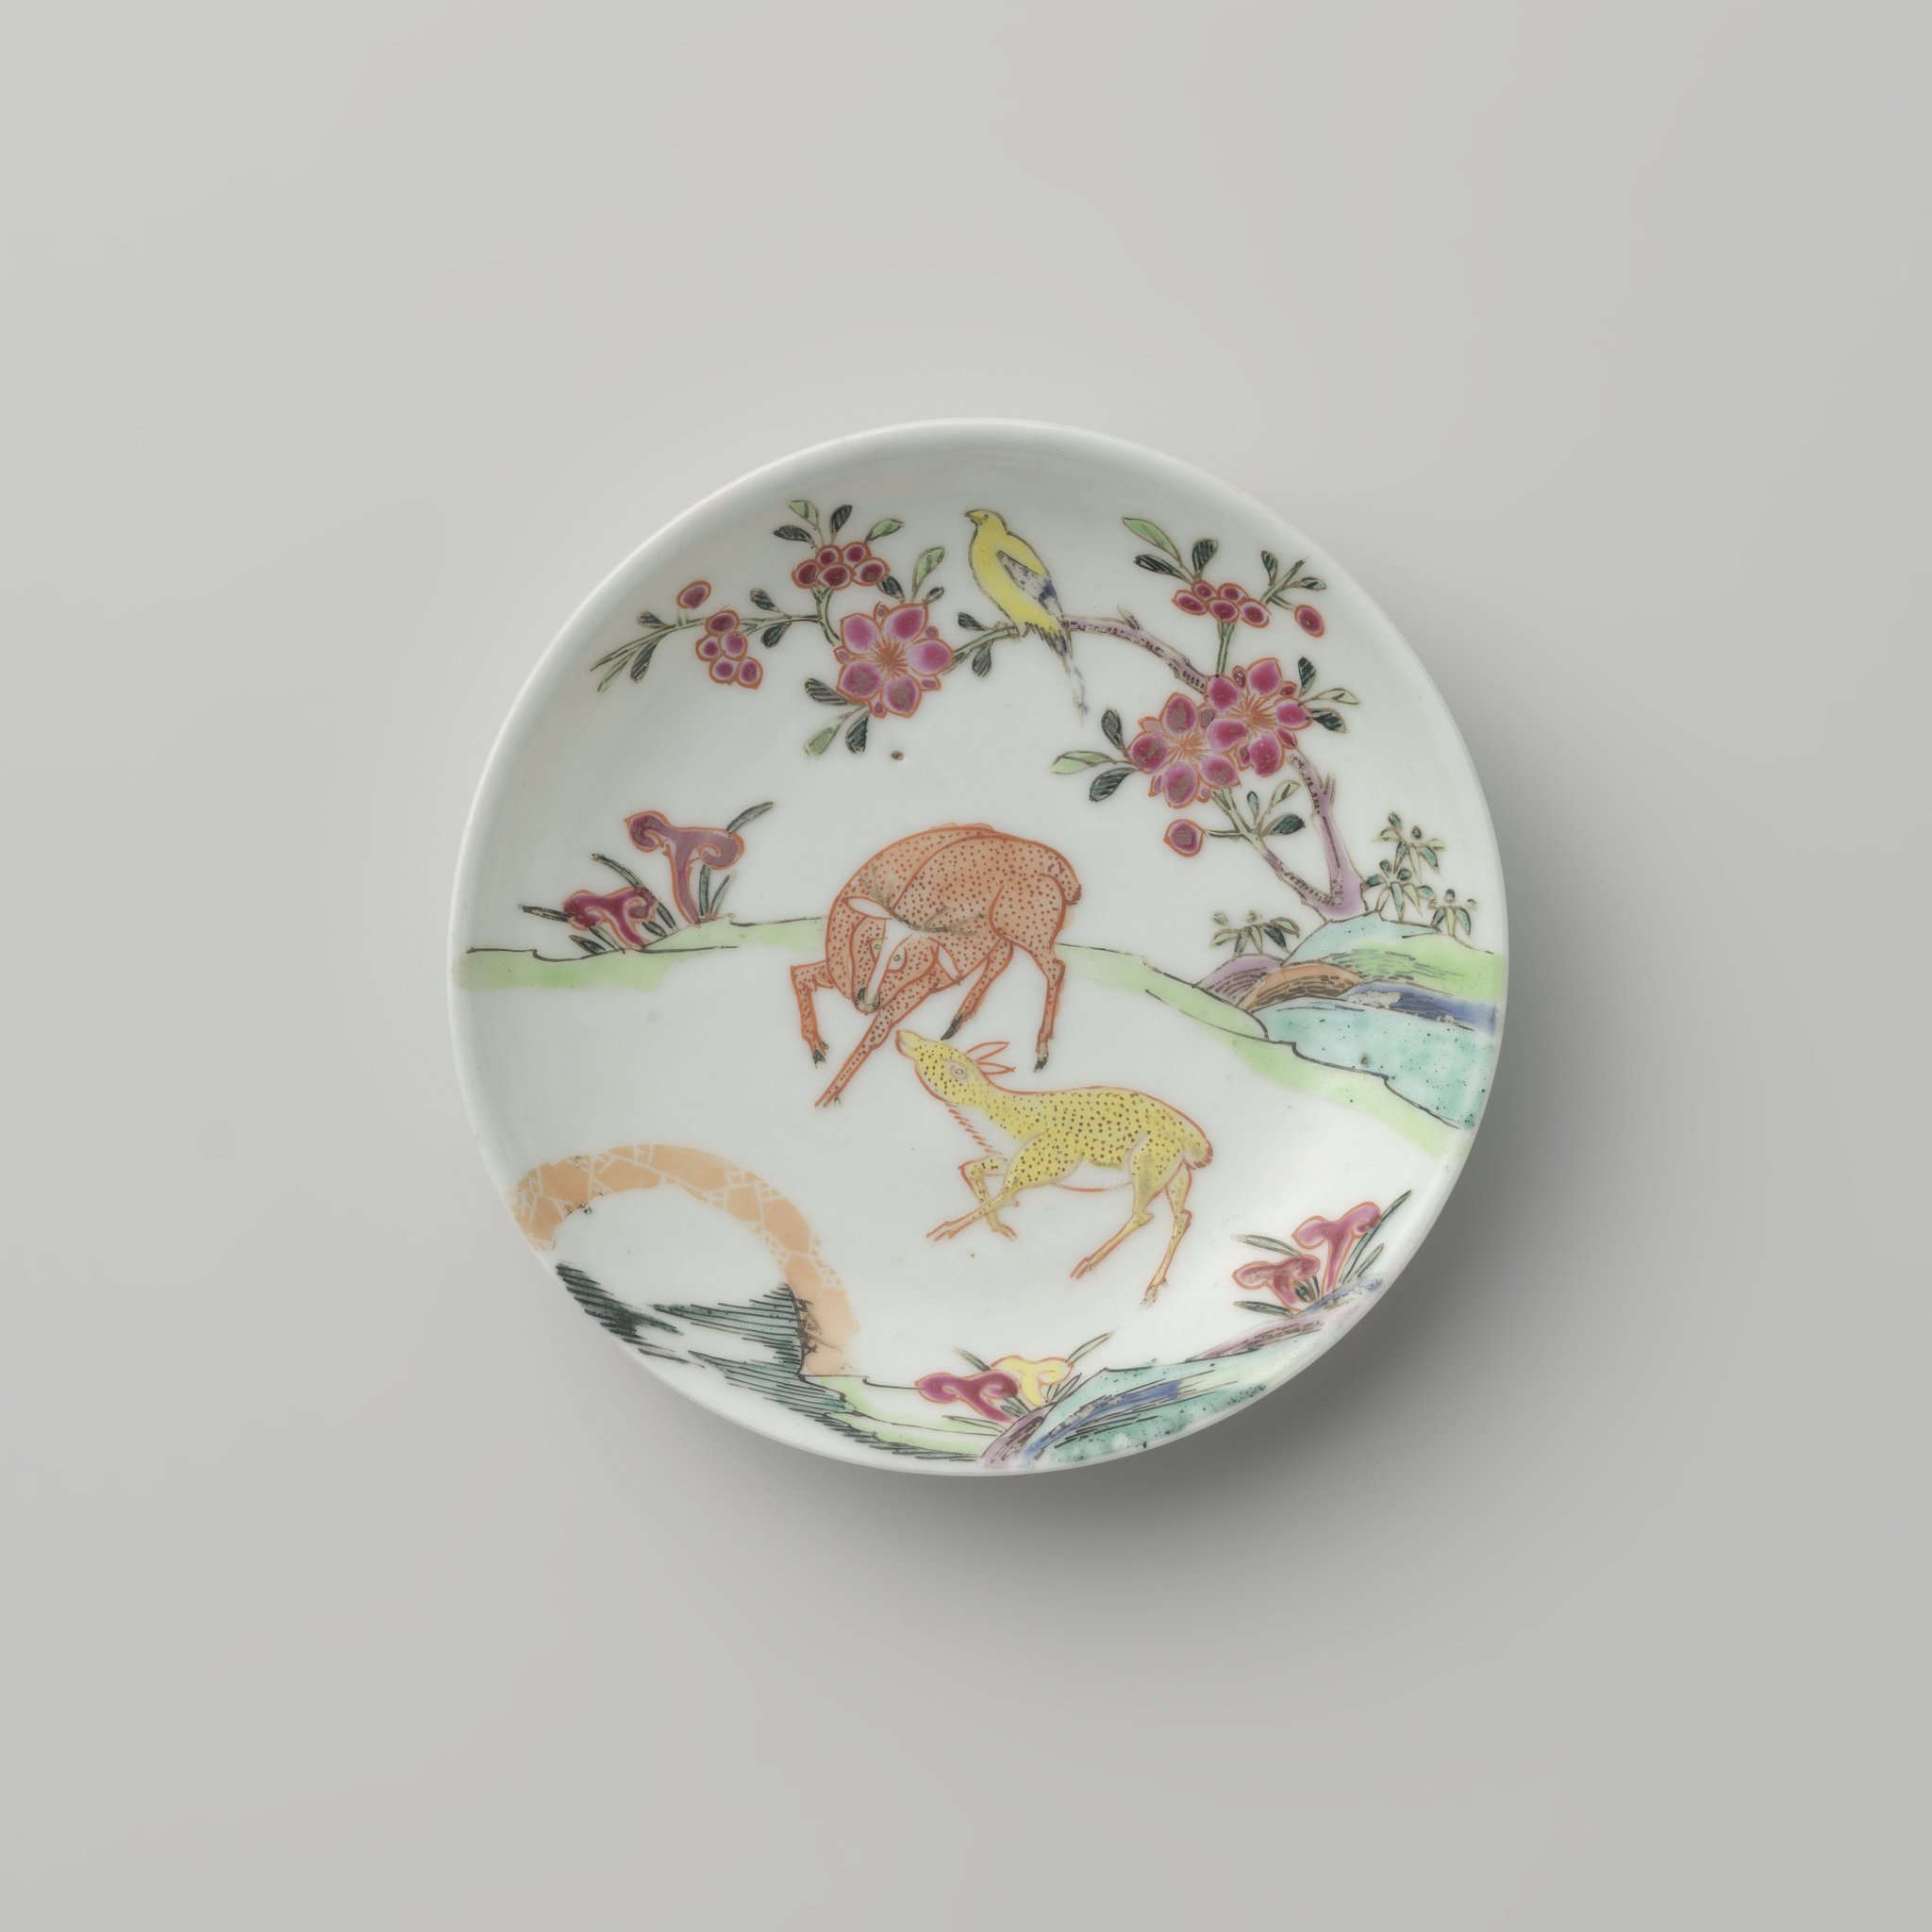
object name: kop en schotel, kop en schotel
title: Saucer with two deer in a landscape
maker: Anonymous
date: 1725-1749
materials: glaze, paint, porcelain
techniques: firing, turning, vitrification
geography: china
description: Schotel van porselein, beschilderd op het glazuur in blauw, rood, roze, groen, geel en zwart. Op het plat van de schotel twee herten in een landschap met paddestoelen (lingzhi) en een vogel op een bloeiende prunus. Famille rose.